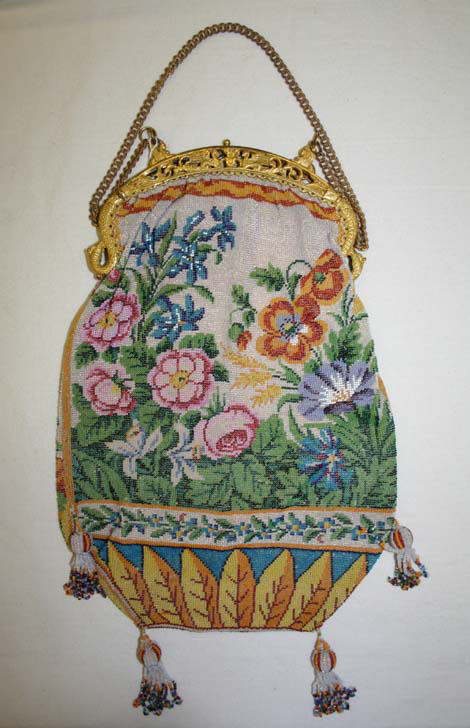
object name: bag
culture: french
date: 1820-1830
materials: metal